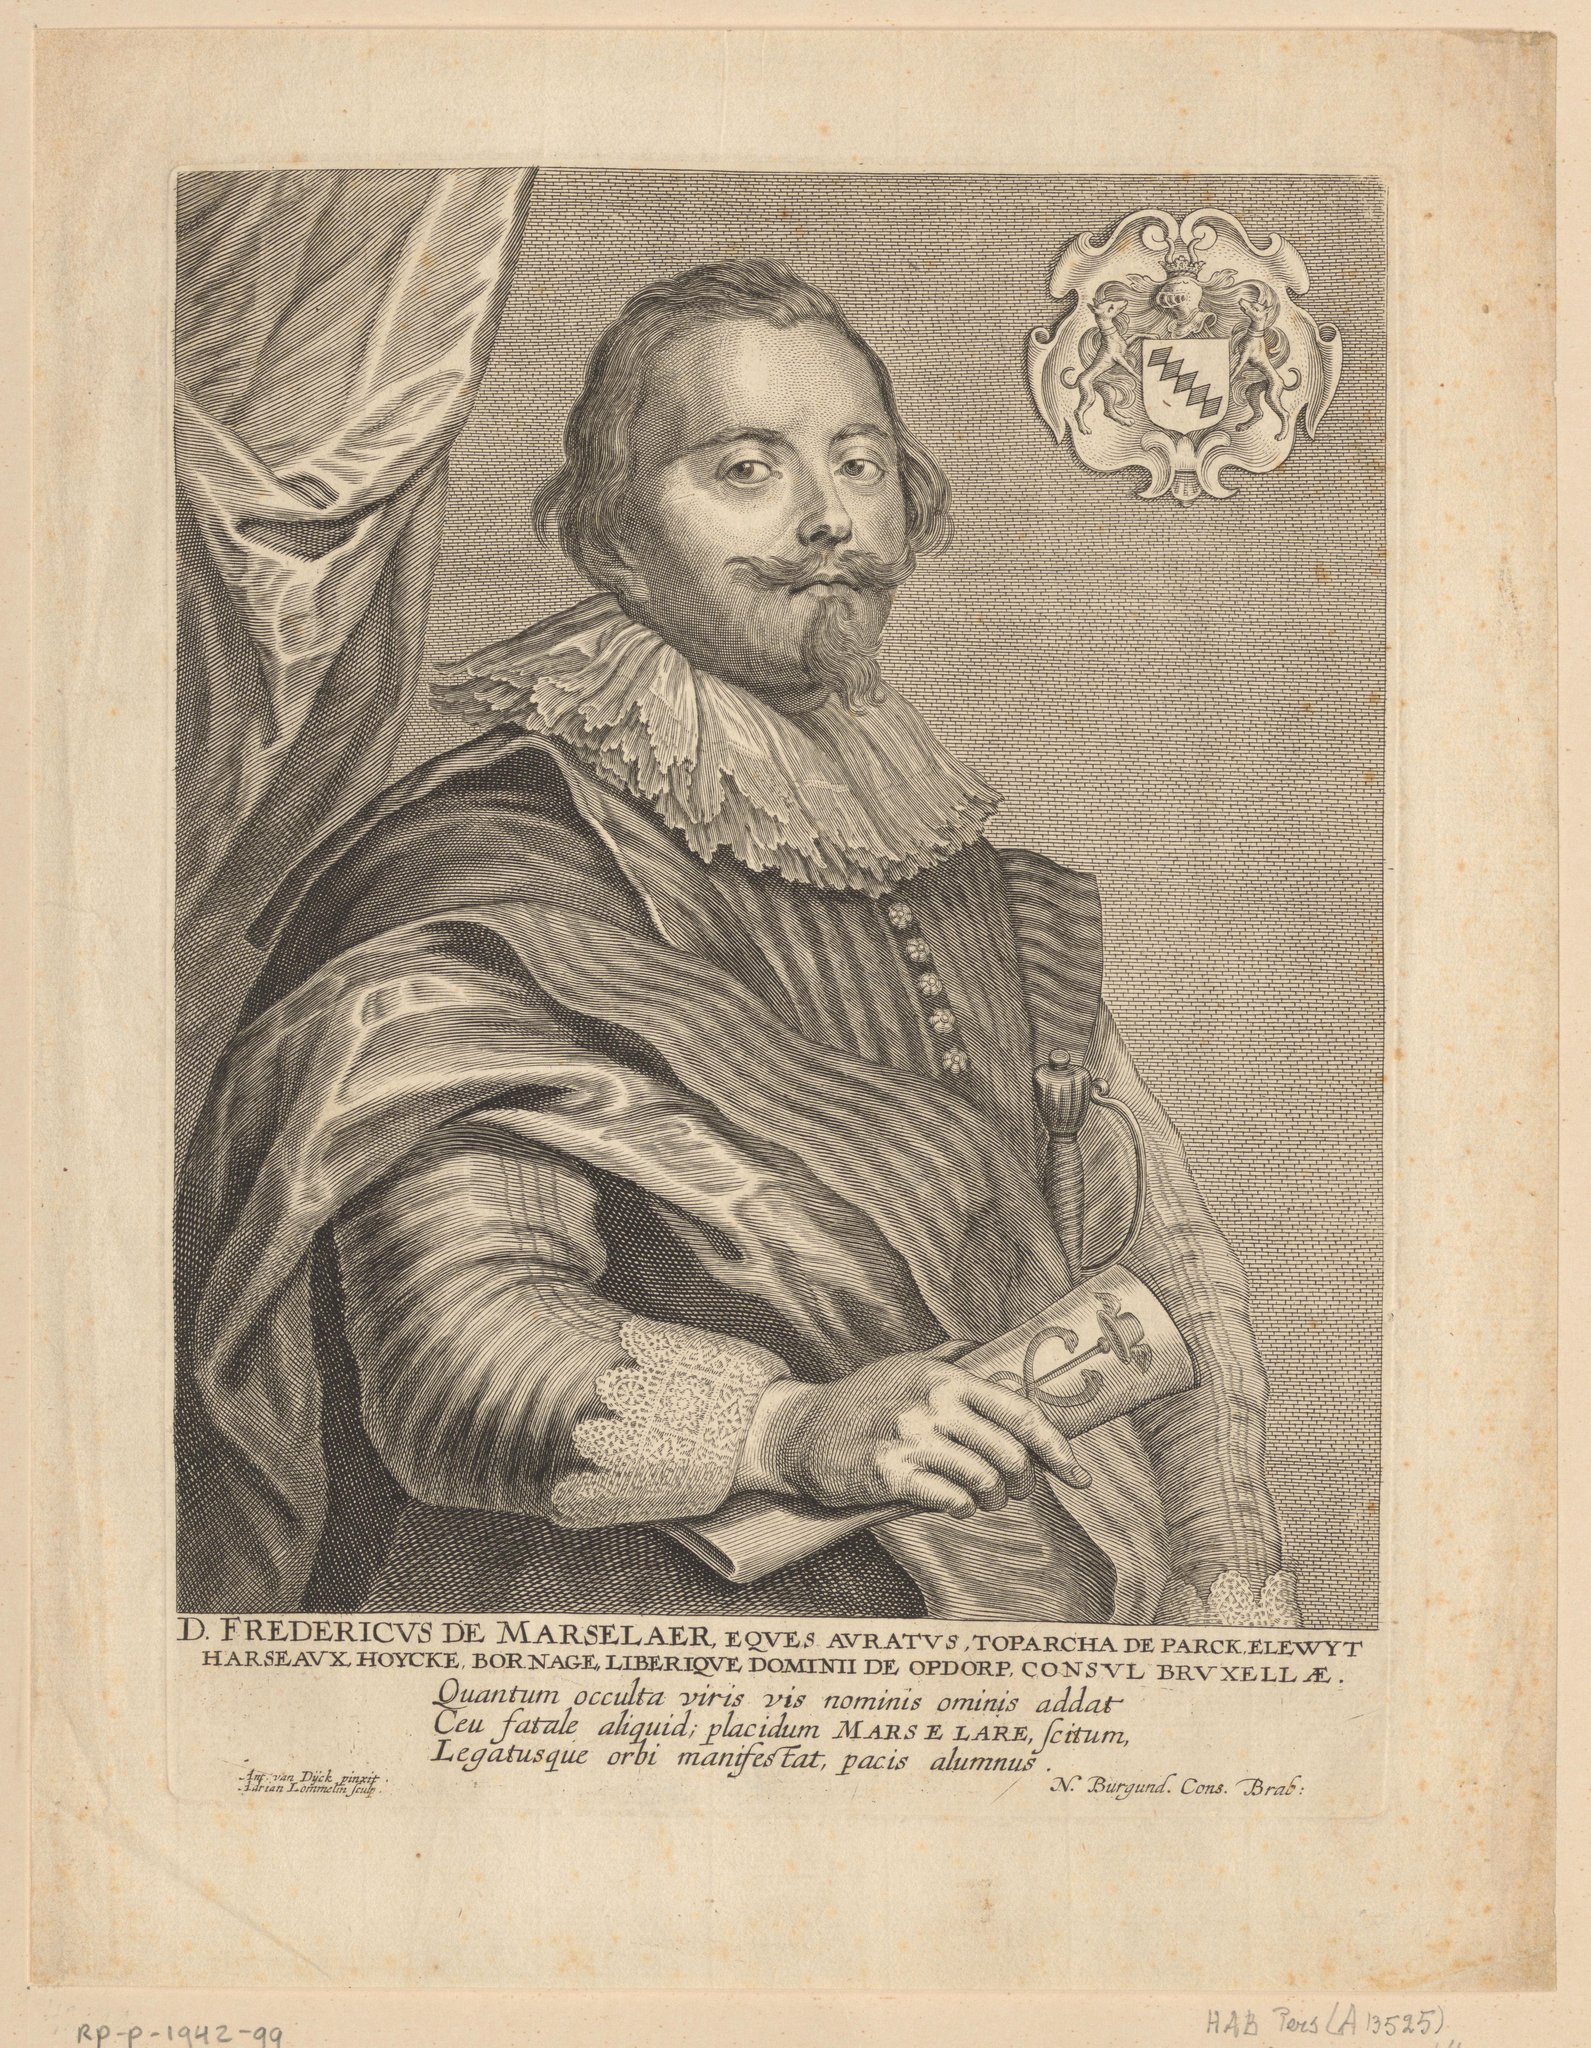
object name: print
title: Portret van Frederik de Marselaer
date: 1630-1677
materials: paper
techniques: engraving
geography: antwerp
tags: mayor, burgomaster, historical persons, armorial bearing, heraldry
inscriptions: collector's mark: Lugt 2228, collector's mark: Lugt 2760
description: Met onderschrift en drieregelig vers in het Latijn onder het portret.